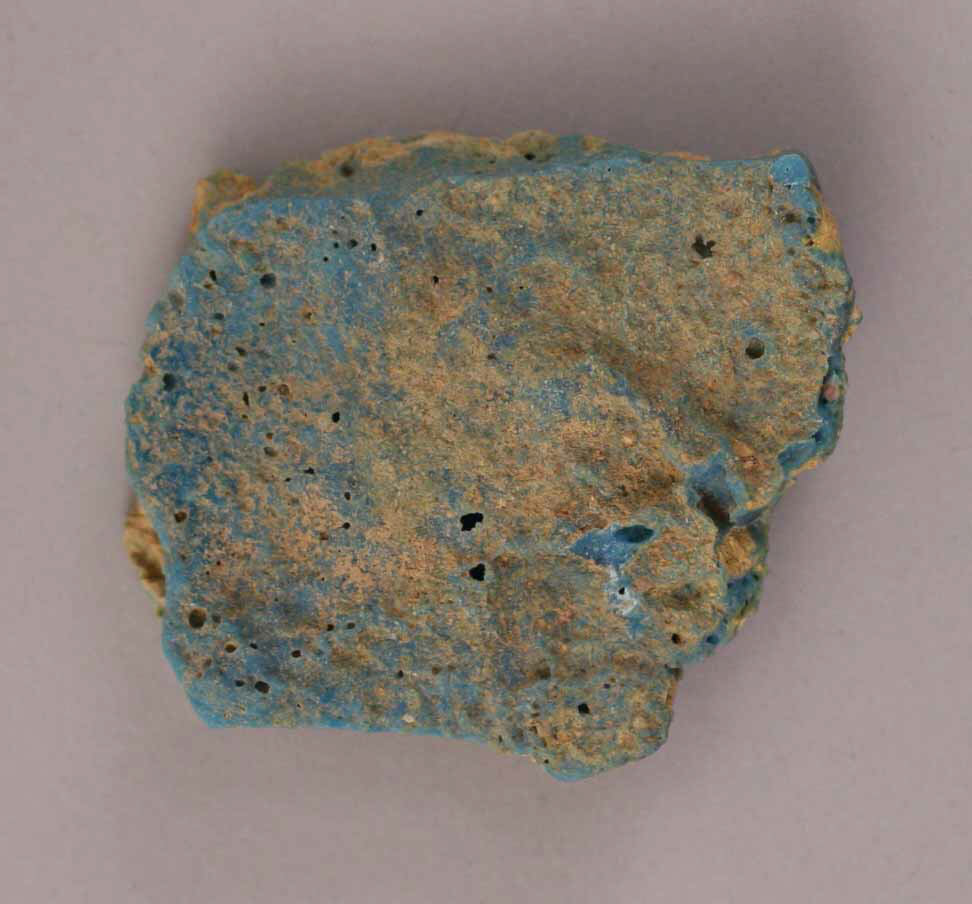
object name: fragment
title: Ceramic Fragment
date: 801-900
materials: earthenware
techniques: glazing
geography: iraq